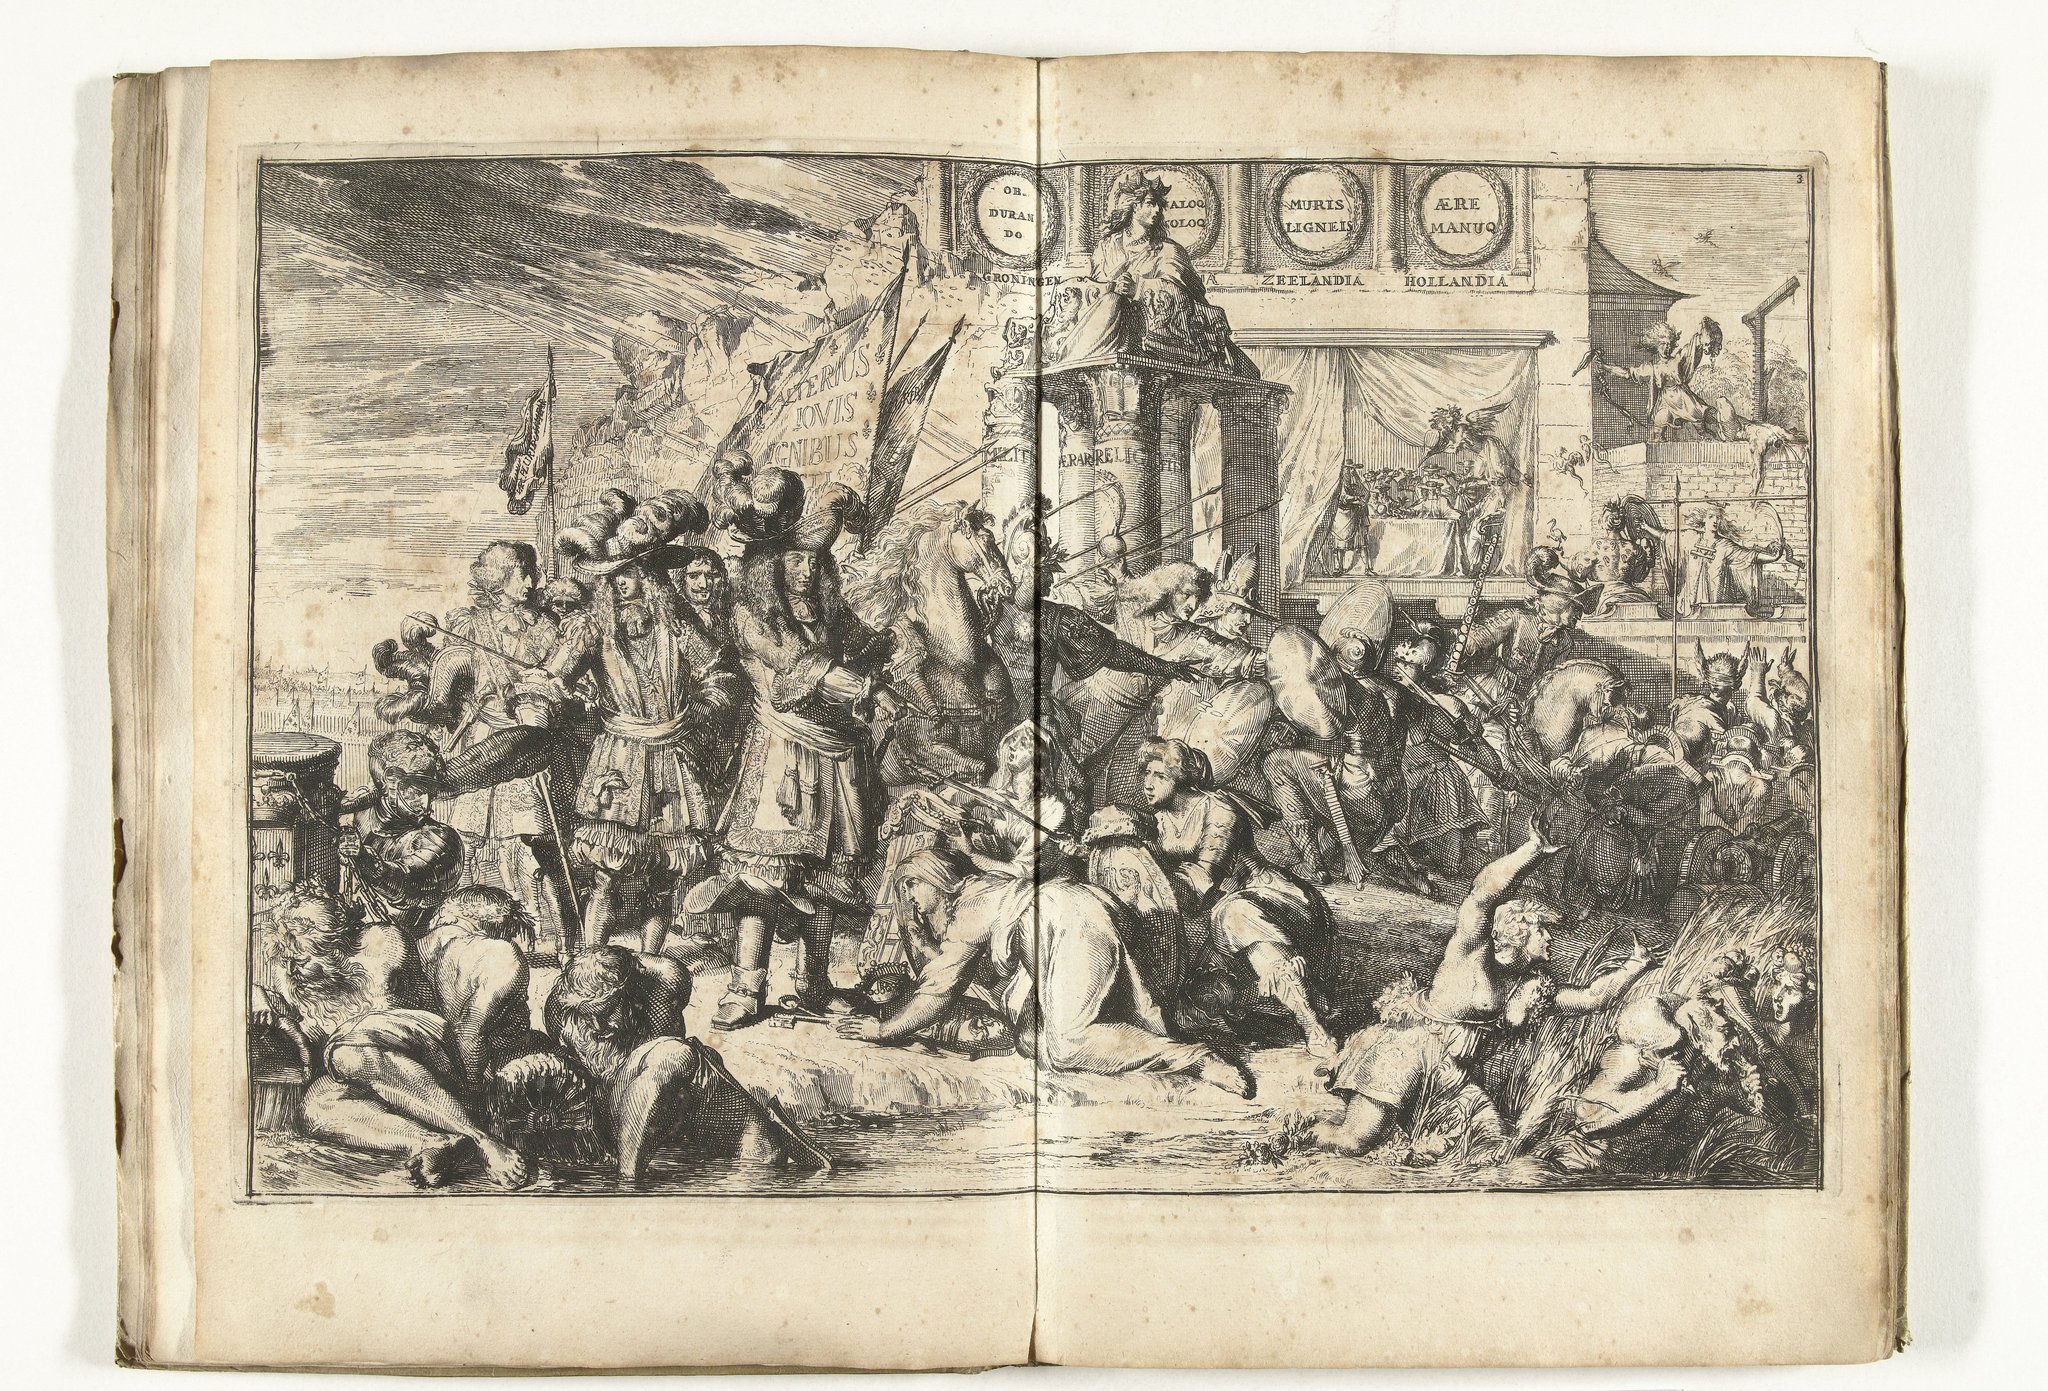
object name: propagandaprent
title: Franse invasie en verbreking van de eenheid van de Unie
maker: romeyn de hooghe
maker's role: draughtsman, goldsmith, painter, print maker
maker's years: 1645-1708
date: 1674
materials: paper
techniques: engraving, etching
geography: amsterdam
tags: lodewijk xiv (koning van frankrijk), netherlands, rampjaar (disaster year)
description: Franse invasie en verbreking van de eenheid van de Unie in 1672. De provincies Utrecht, Gelderland en Overijssel werpen zich aan de voeten van Lodewijk XIV. Anderen vluchten of worden als gevangenen geboeid. Midden achter zit de Nederlandse Maagd op een plateau op vier zuilen, hierachter de namen van de overgebleven provincies Groningen, Friesland, Zeeland en Holland. Op de achtergrond duivels en een onthoofding. Genummerd rechtsboven: 3.